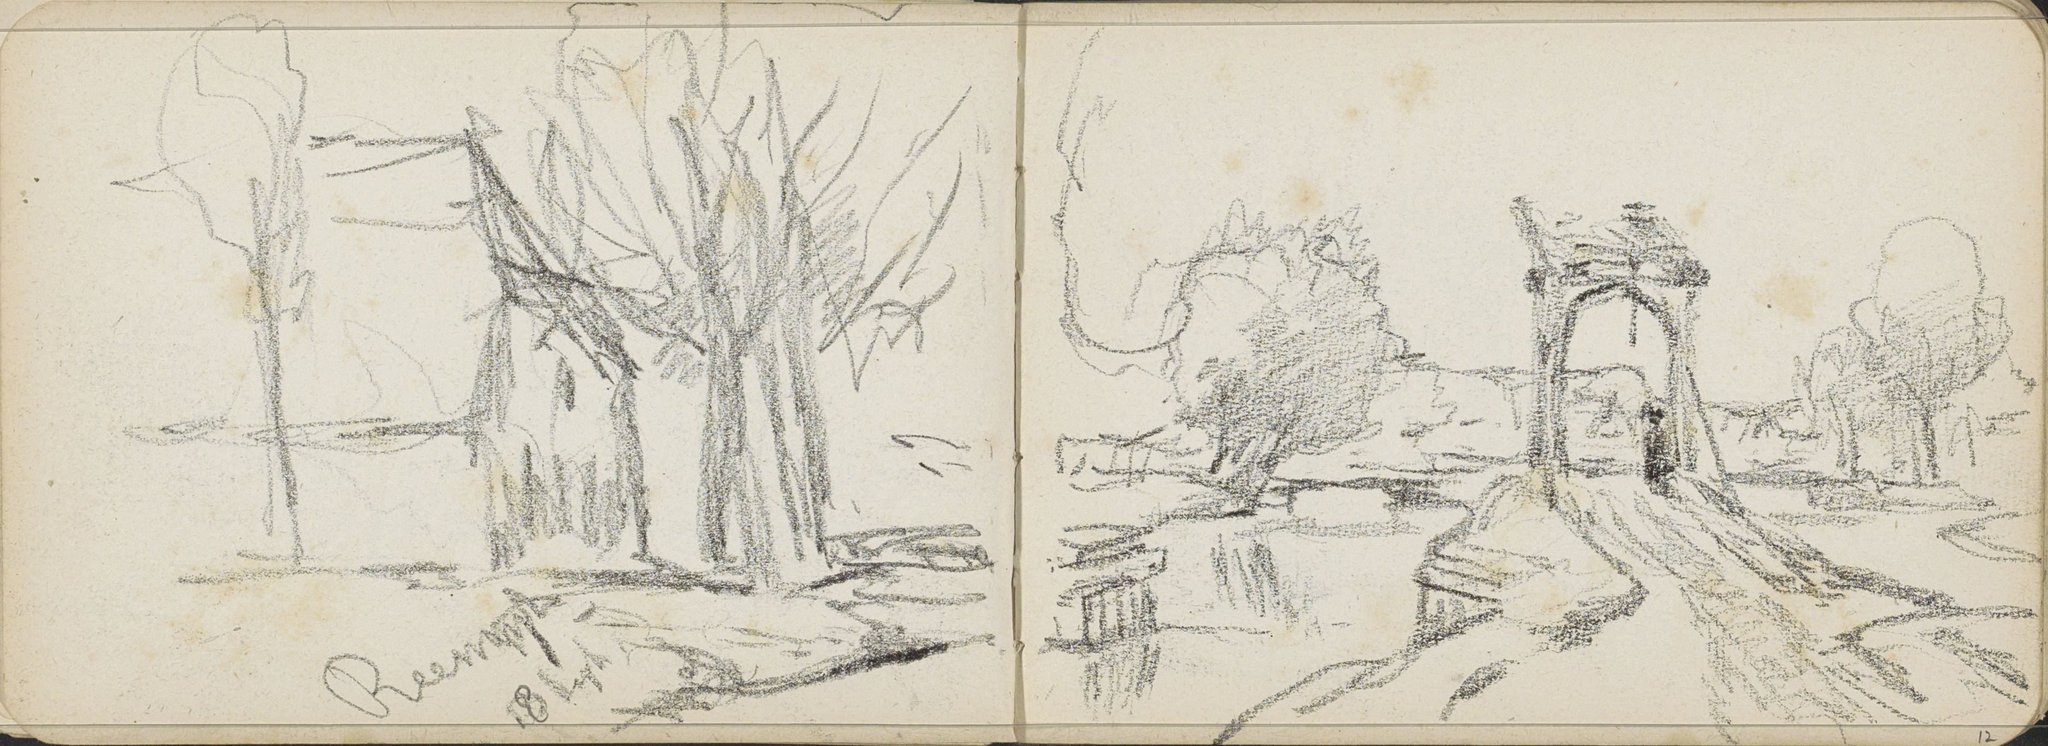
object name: sketchbook leaf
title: Figuur op een brug te Reeuwijk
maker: willem cornelis rip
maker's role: draughtsman, painter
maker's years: 1856-1922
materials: chalk, paper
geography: reeuwijk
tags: landscapes with waters, waterscapes, seascapes (in the temperate zone), bridge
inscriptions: date and inscription: ‘Reewijk/ 18 Sept’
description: Blad 11 verso en 12 recto uit een schetsboek met 44 bladen.